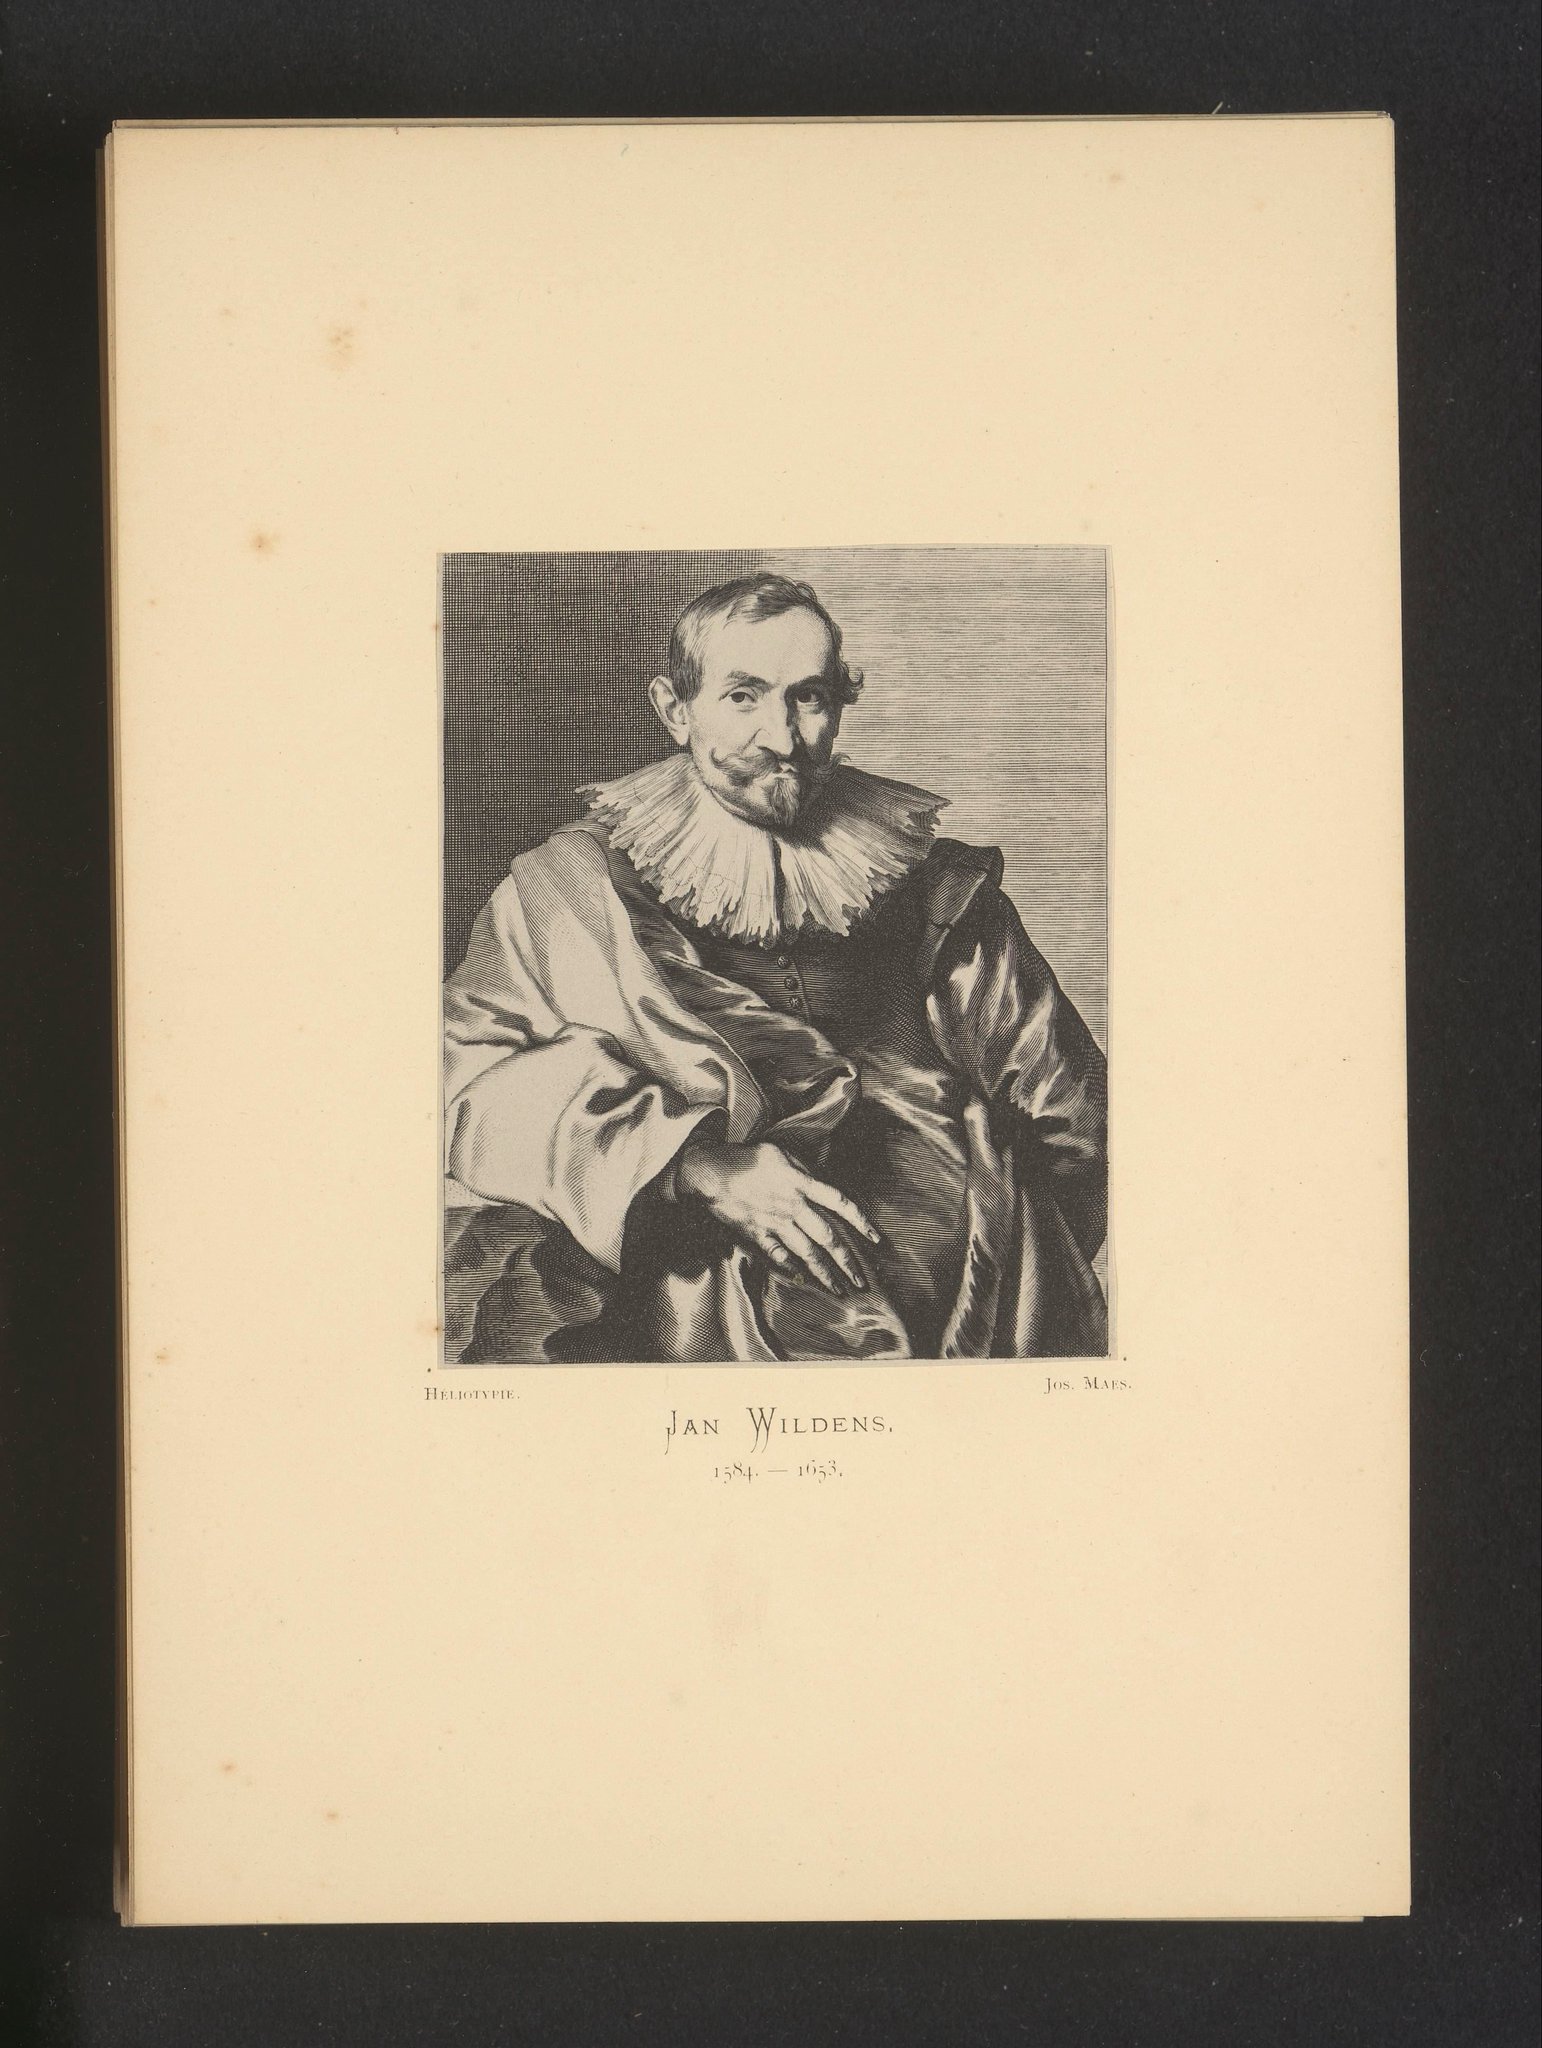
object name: reproduction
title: Reproductie van een gravure van een portret van Jan Wildens door Paulus Pontius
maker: joseph maes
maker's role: fotograaf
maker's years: 1838-1908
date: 1872-1877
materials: cardboard, paper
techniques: photograph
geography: antwerp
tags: antwerp, painter, draughtsman, jan wildens, historical persons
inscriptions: inscription: ‘1584. - 1653.’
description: Deze prent maakt deel uit van een omslag met 150 prenten en een katern met een lijst van afbeeldingen.